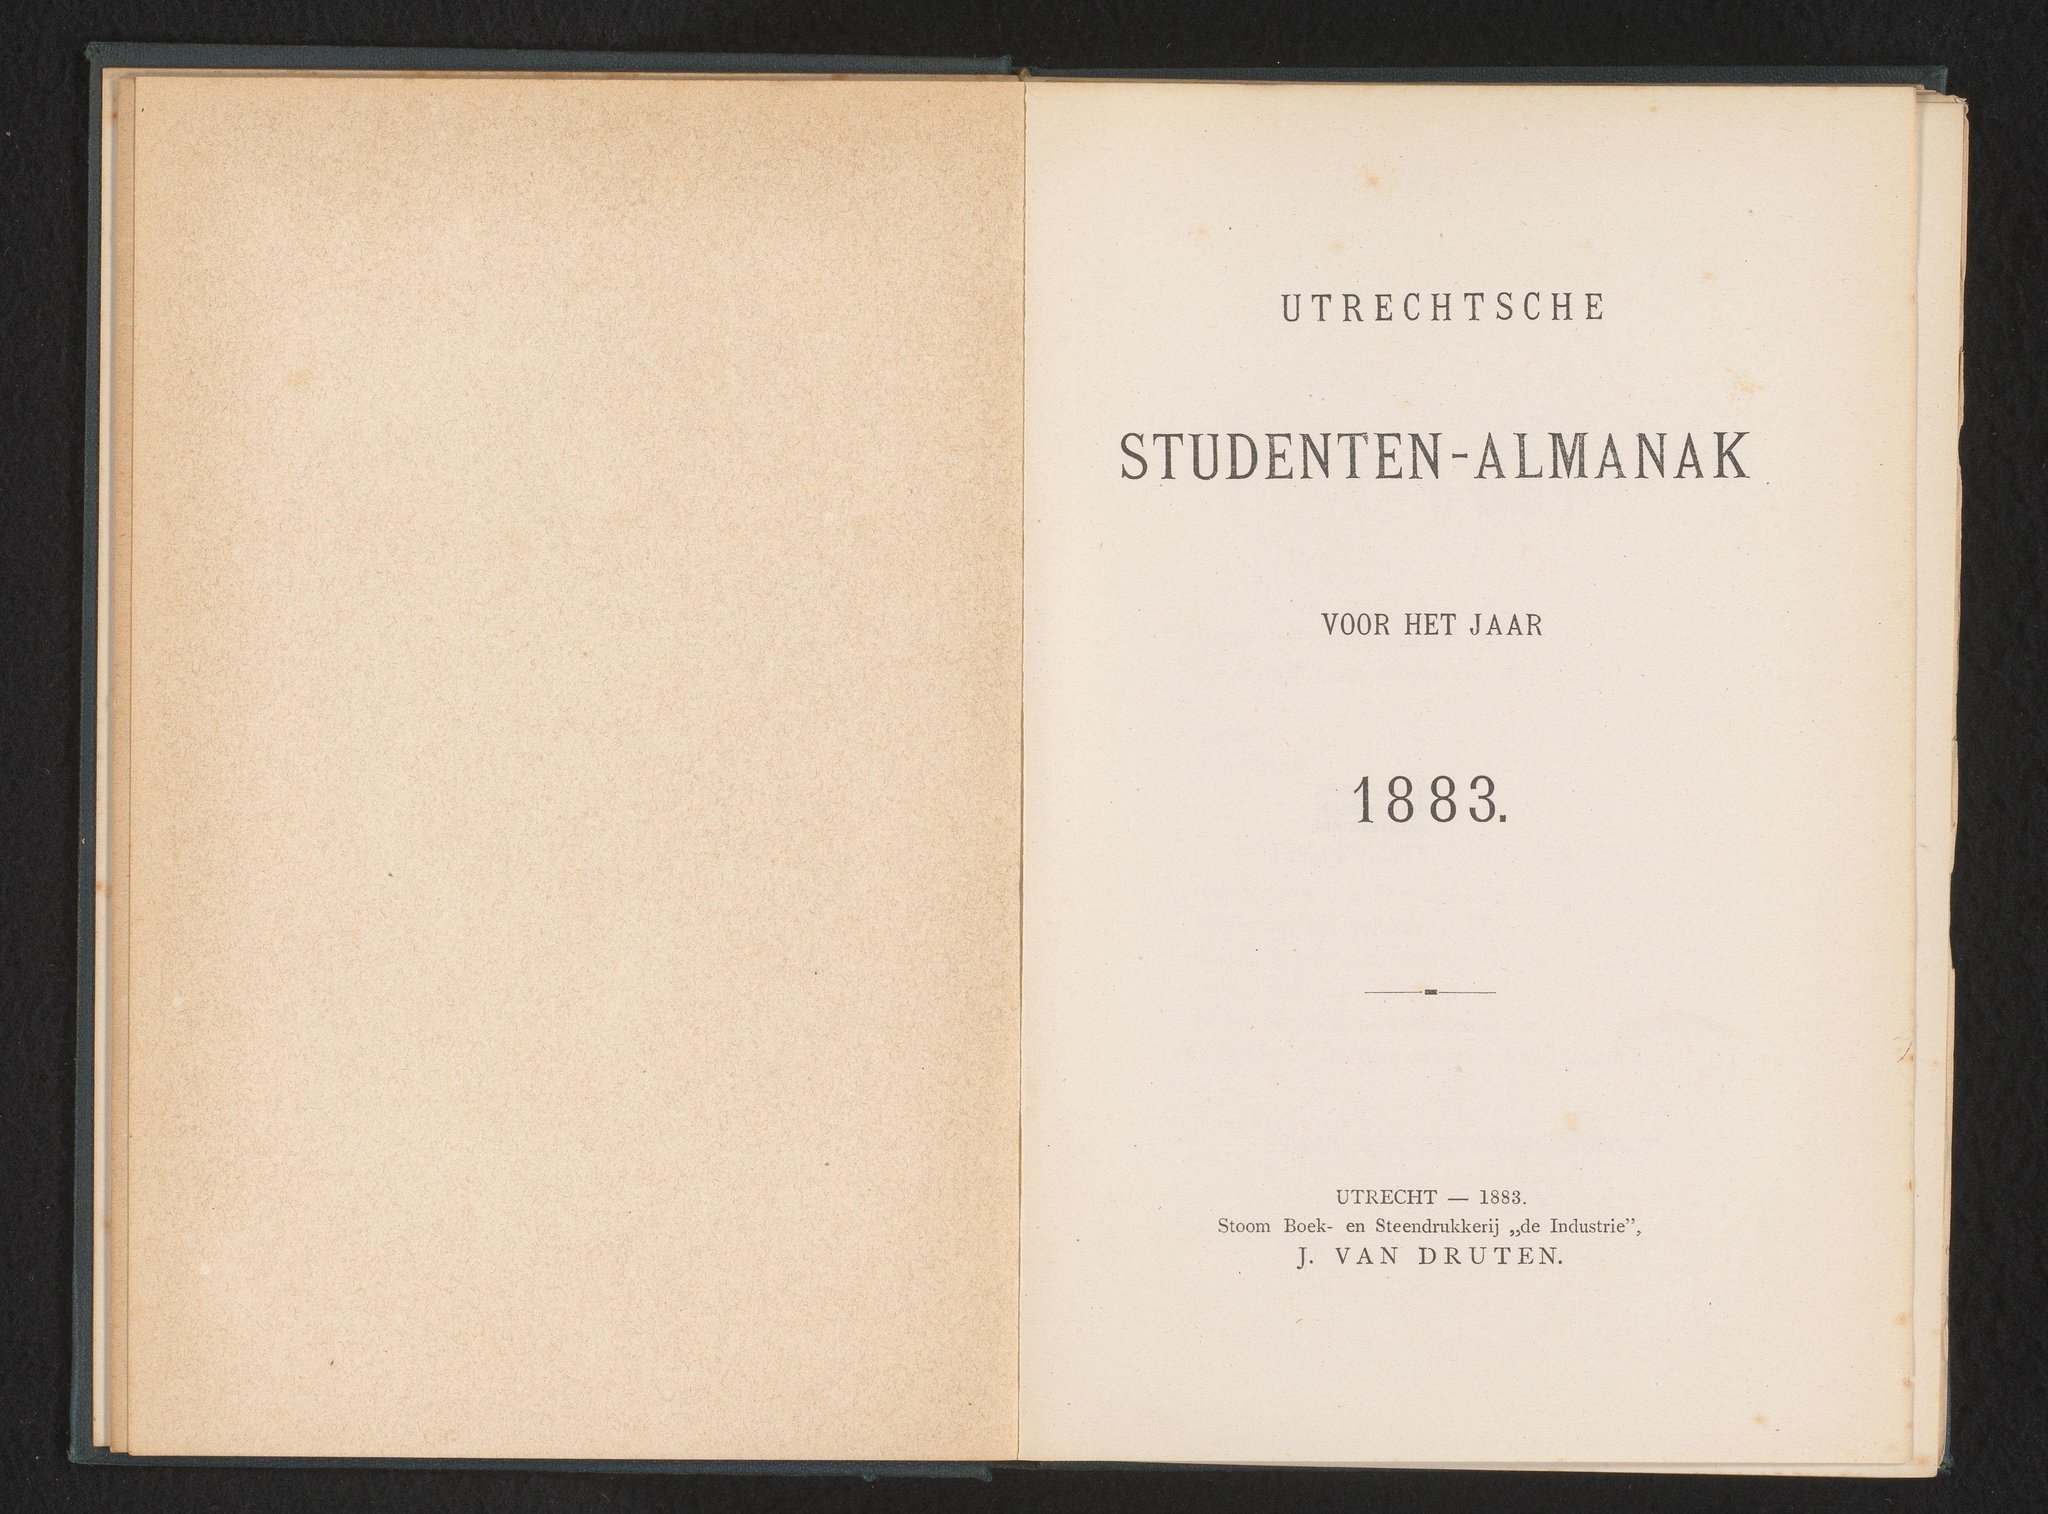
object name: book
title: Utrechtsche studenten-almanak voor het jaar 1883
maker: j. van druten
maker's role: publisher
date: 1883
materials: paper, cardboard, linen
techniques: albumen print, letterpress printing, lithograph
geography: utrecht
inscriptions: number: ‘450’